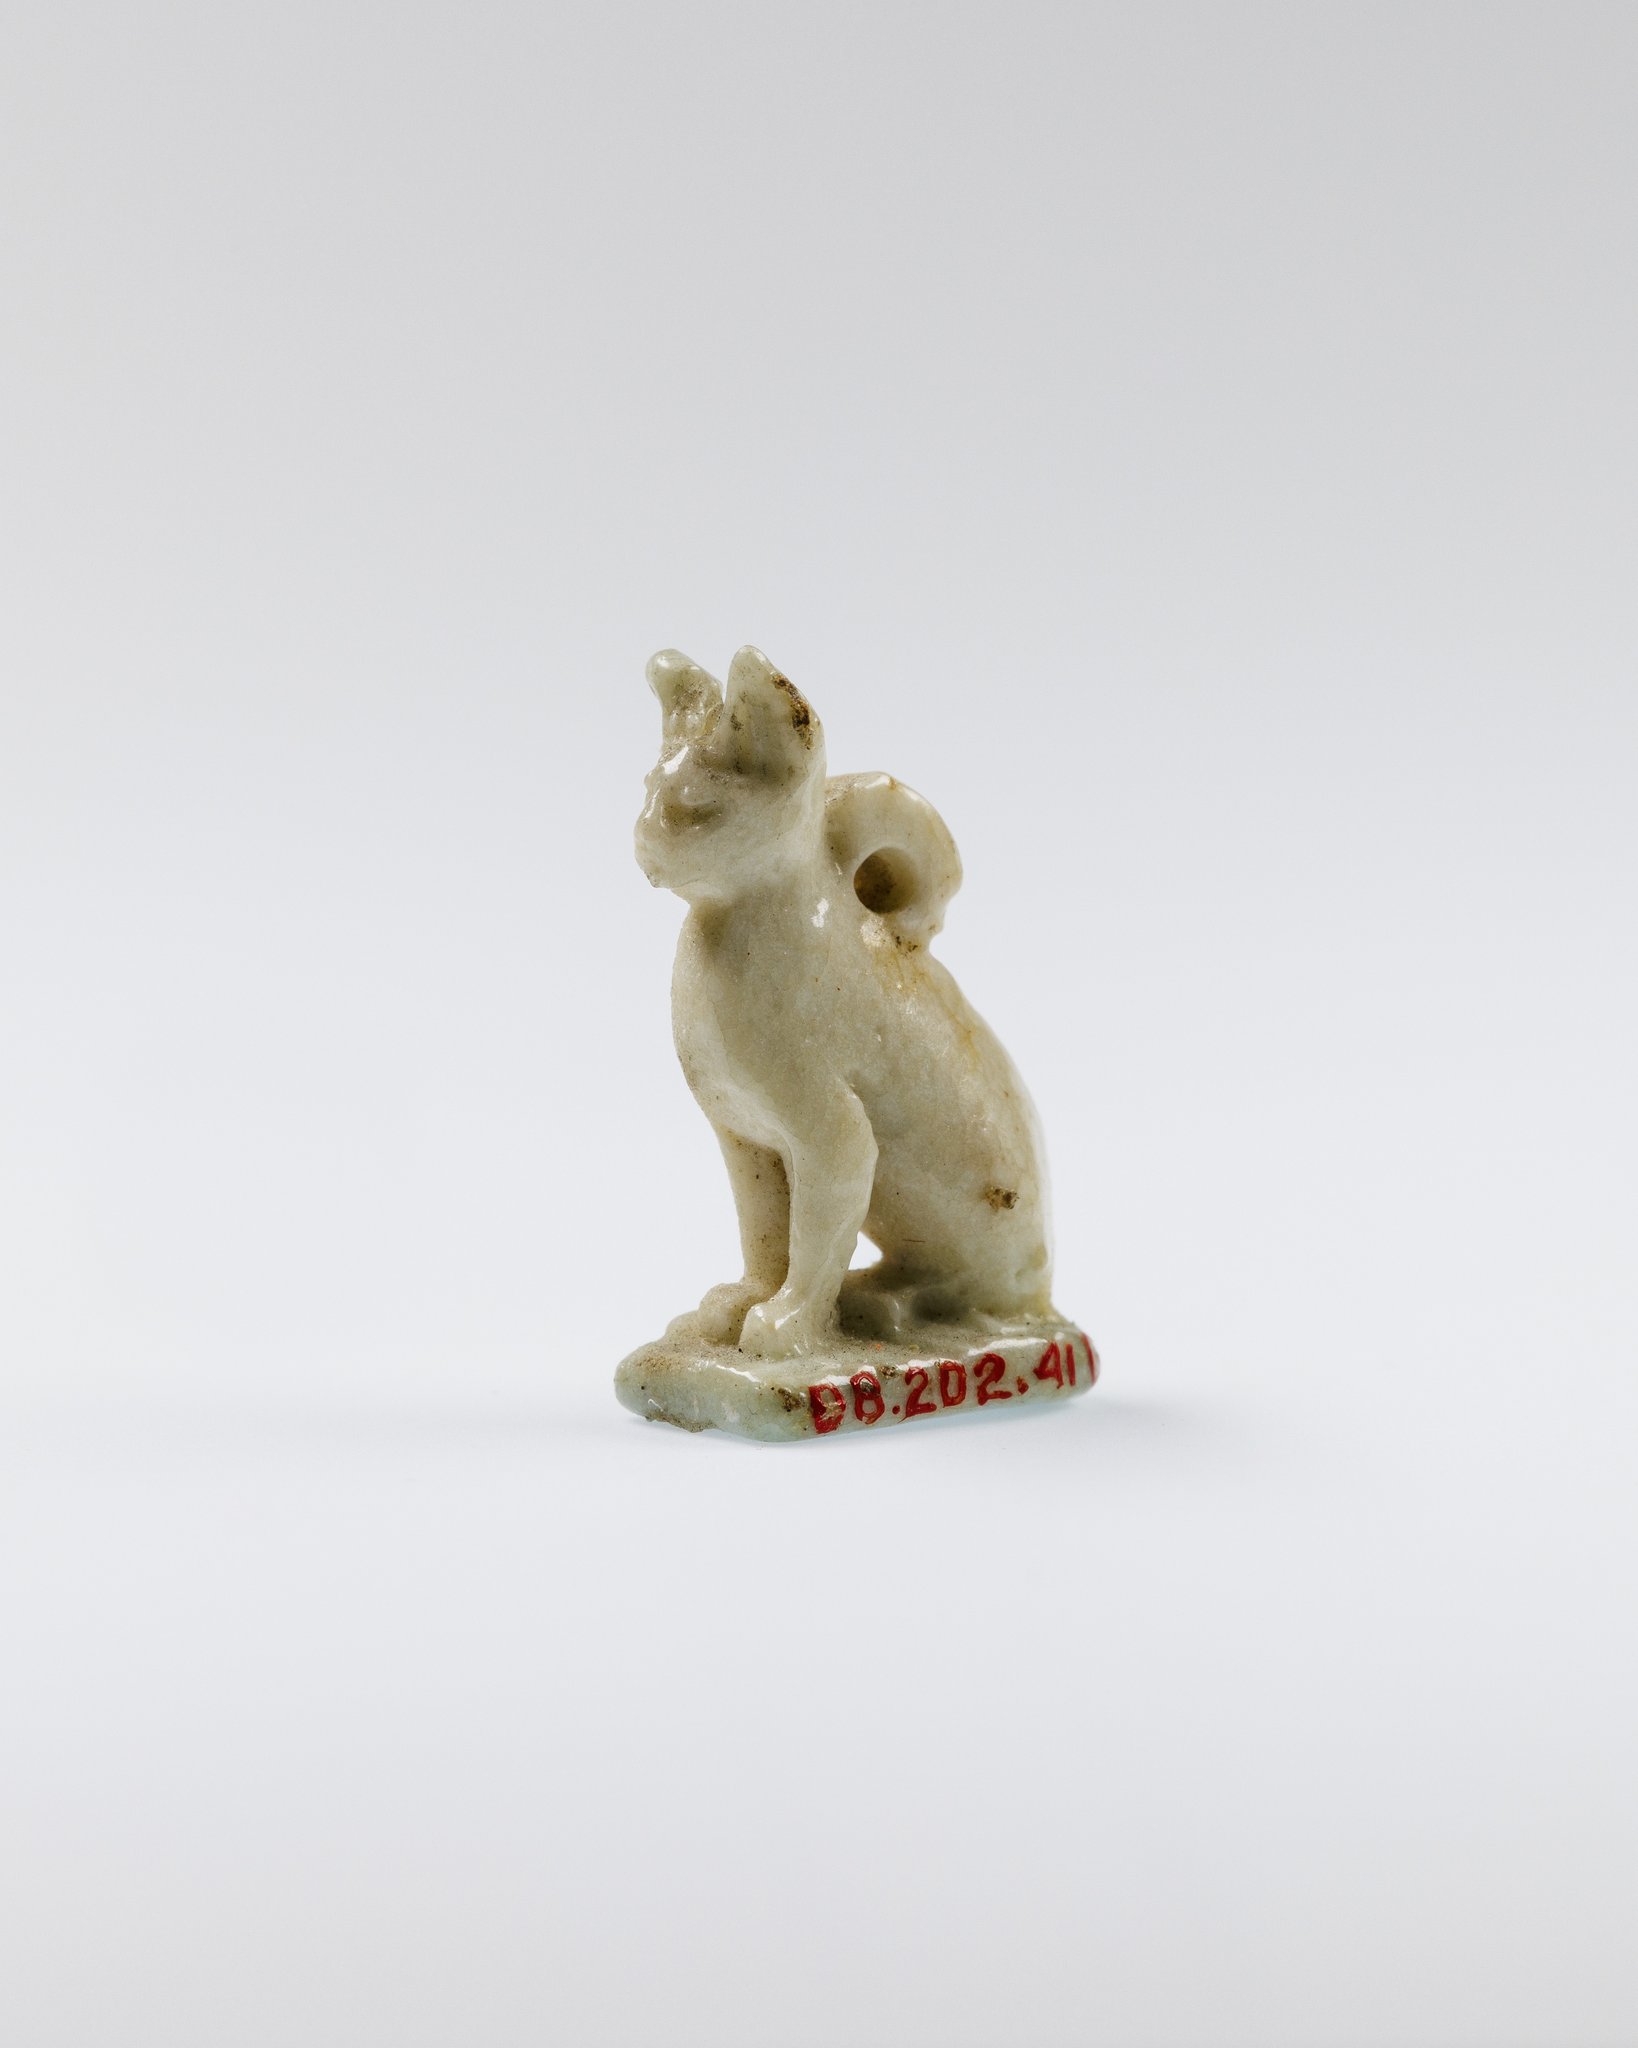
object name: amulet, cat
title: Cat amulet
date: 664-525 BCE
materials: faience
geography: egypt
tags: cats